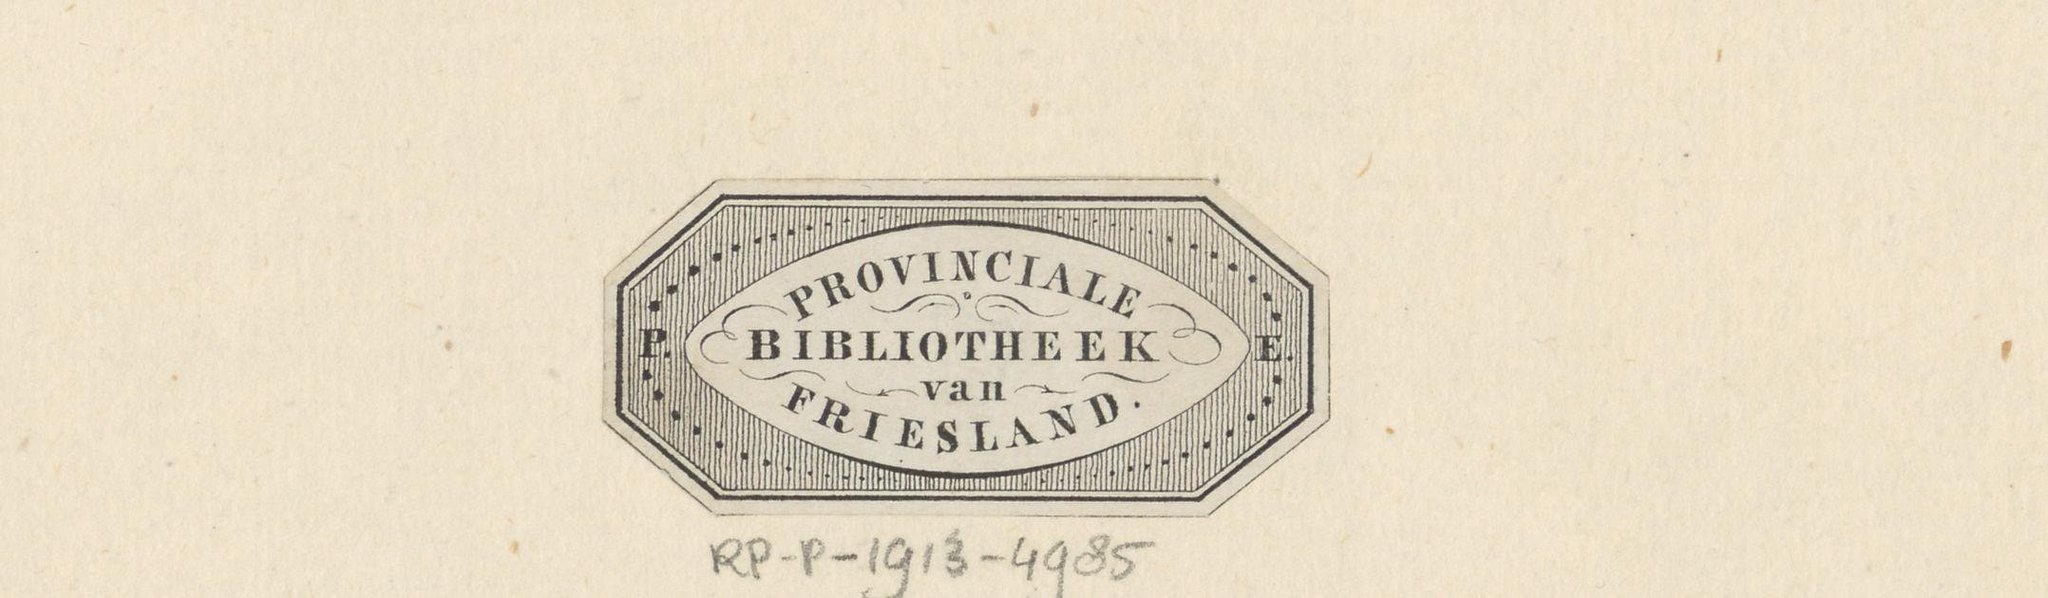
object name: bookplate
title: Ex libris van de Provinciale Bibliotheek van Friesland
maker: Anonymous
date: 1850-1913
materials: paper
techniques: engraving, etching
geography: leeuwarden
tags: provinciale bibliotheek van friesland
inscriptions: collector's mark: Lugt 2760, collector's mark: Lugt 2233